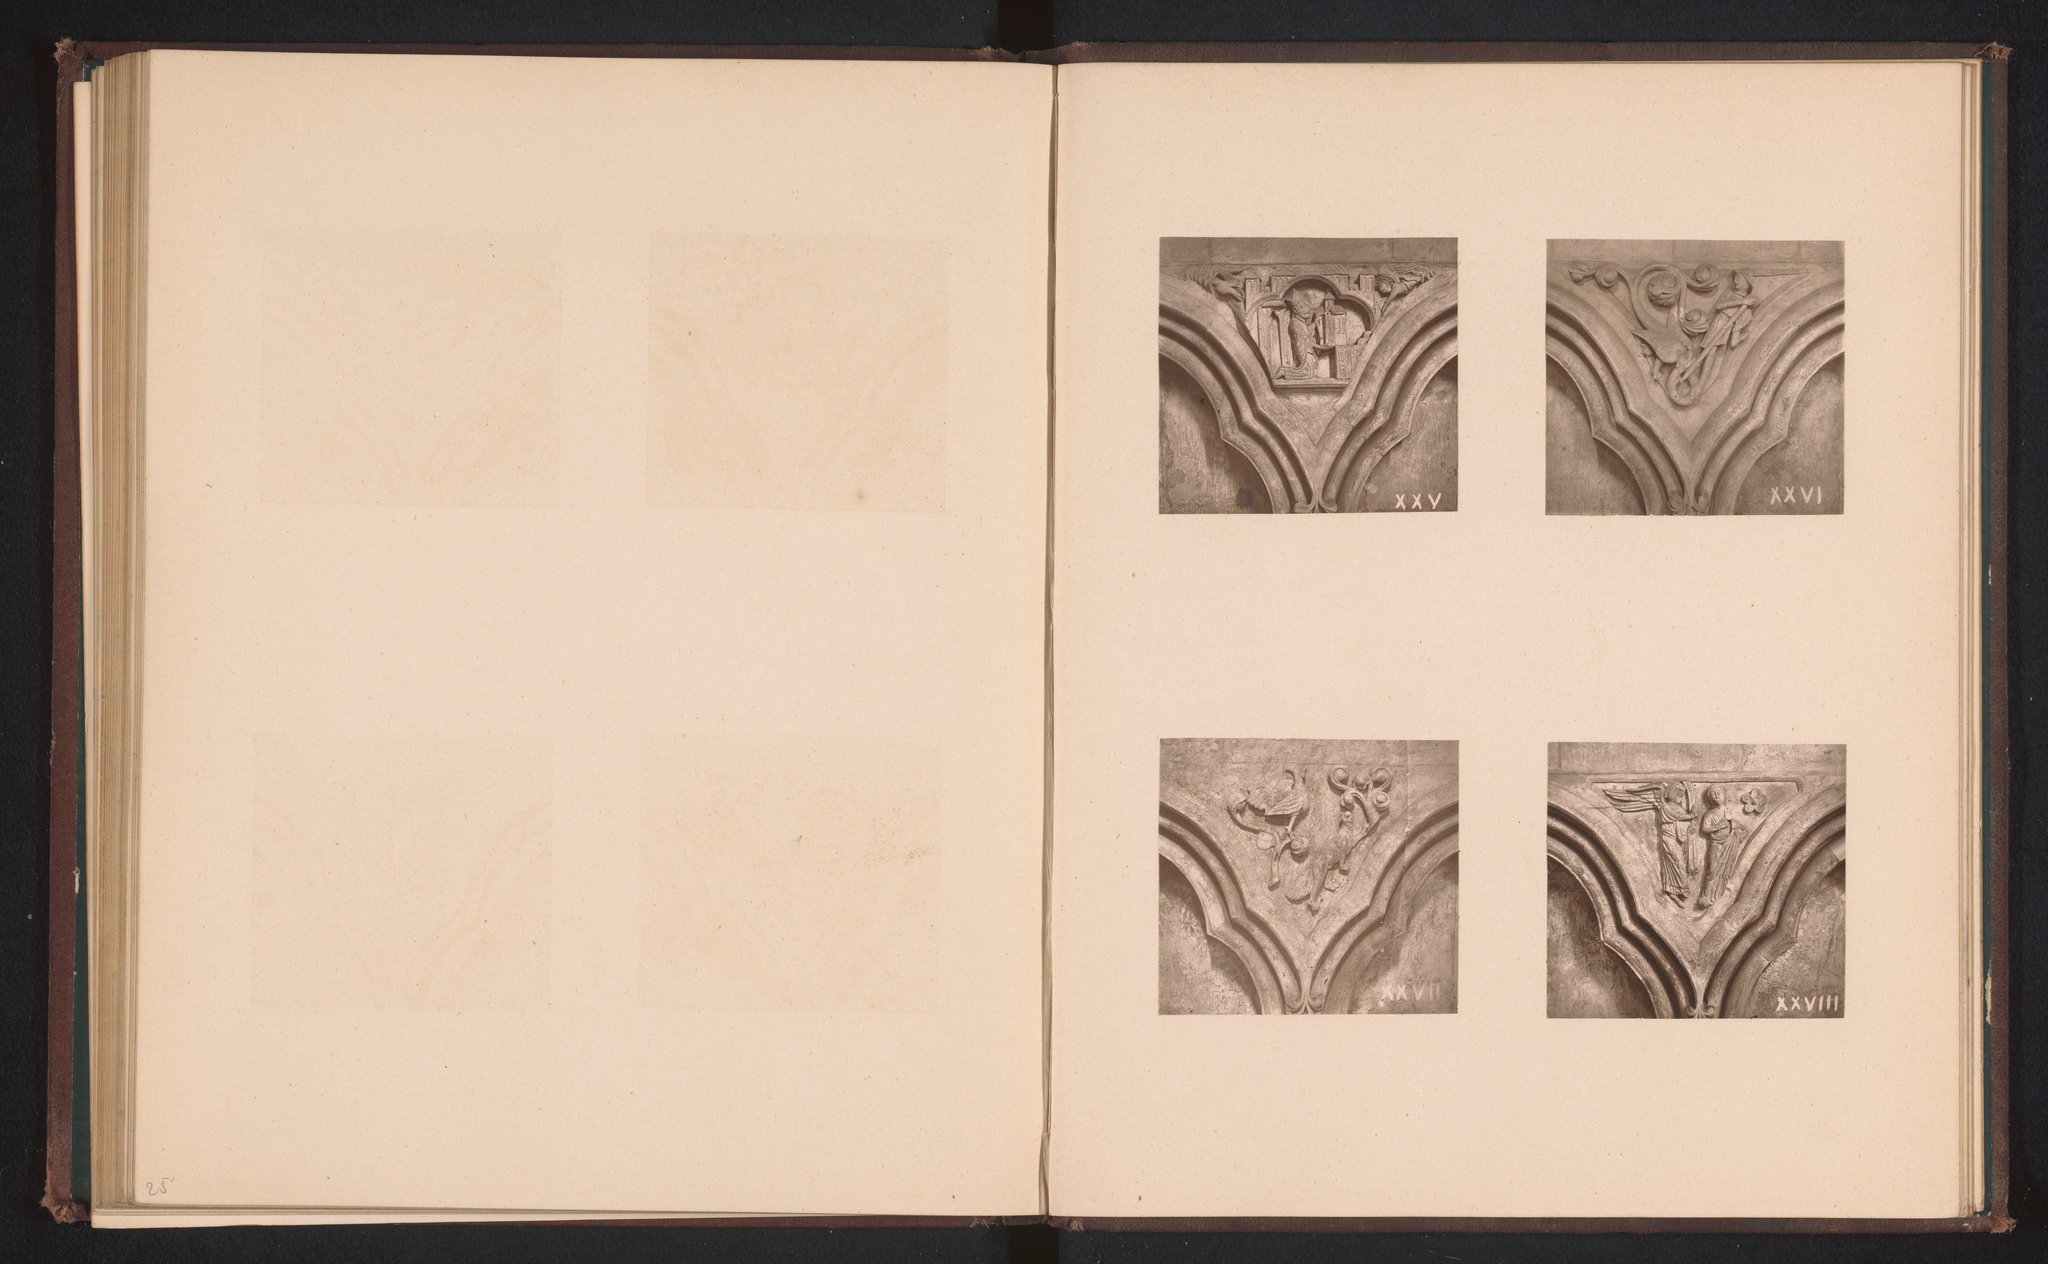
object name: photomechanical print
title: Vier houtsnijwerken in een arcade van de Kathedraal van Worcester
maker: Anonymous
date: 1863-1873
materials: paper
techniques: woodburytype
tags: patron handing over model of church (or chapel), carving ~ applied arts, the annunciation: mary standing, interior of church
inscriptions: number: ‘XXV (...) XXVIII’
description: Linksboven een bisschop met een model van een kerk, rechtsboven een figuur in gevecht met een serpent, linksonder een haan en een vos, rechtsonder de Annunciatie.